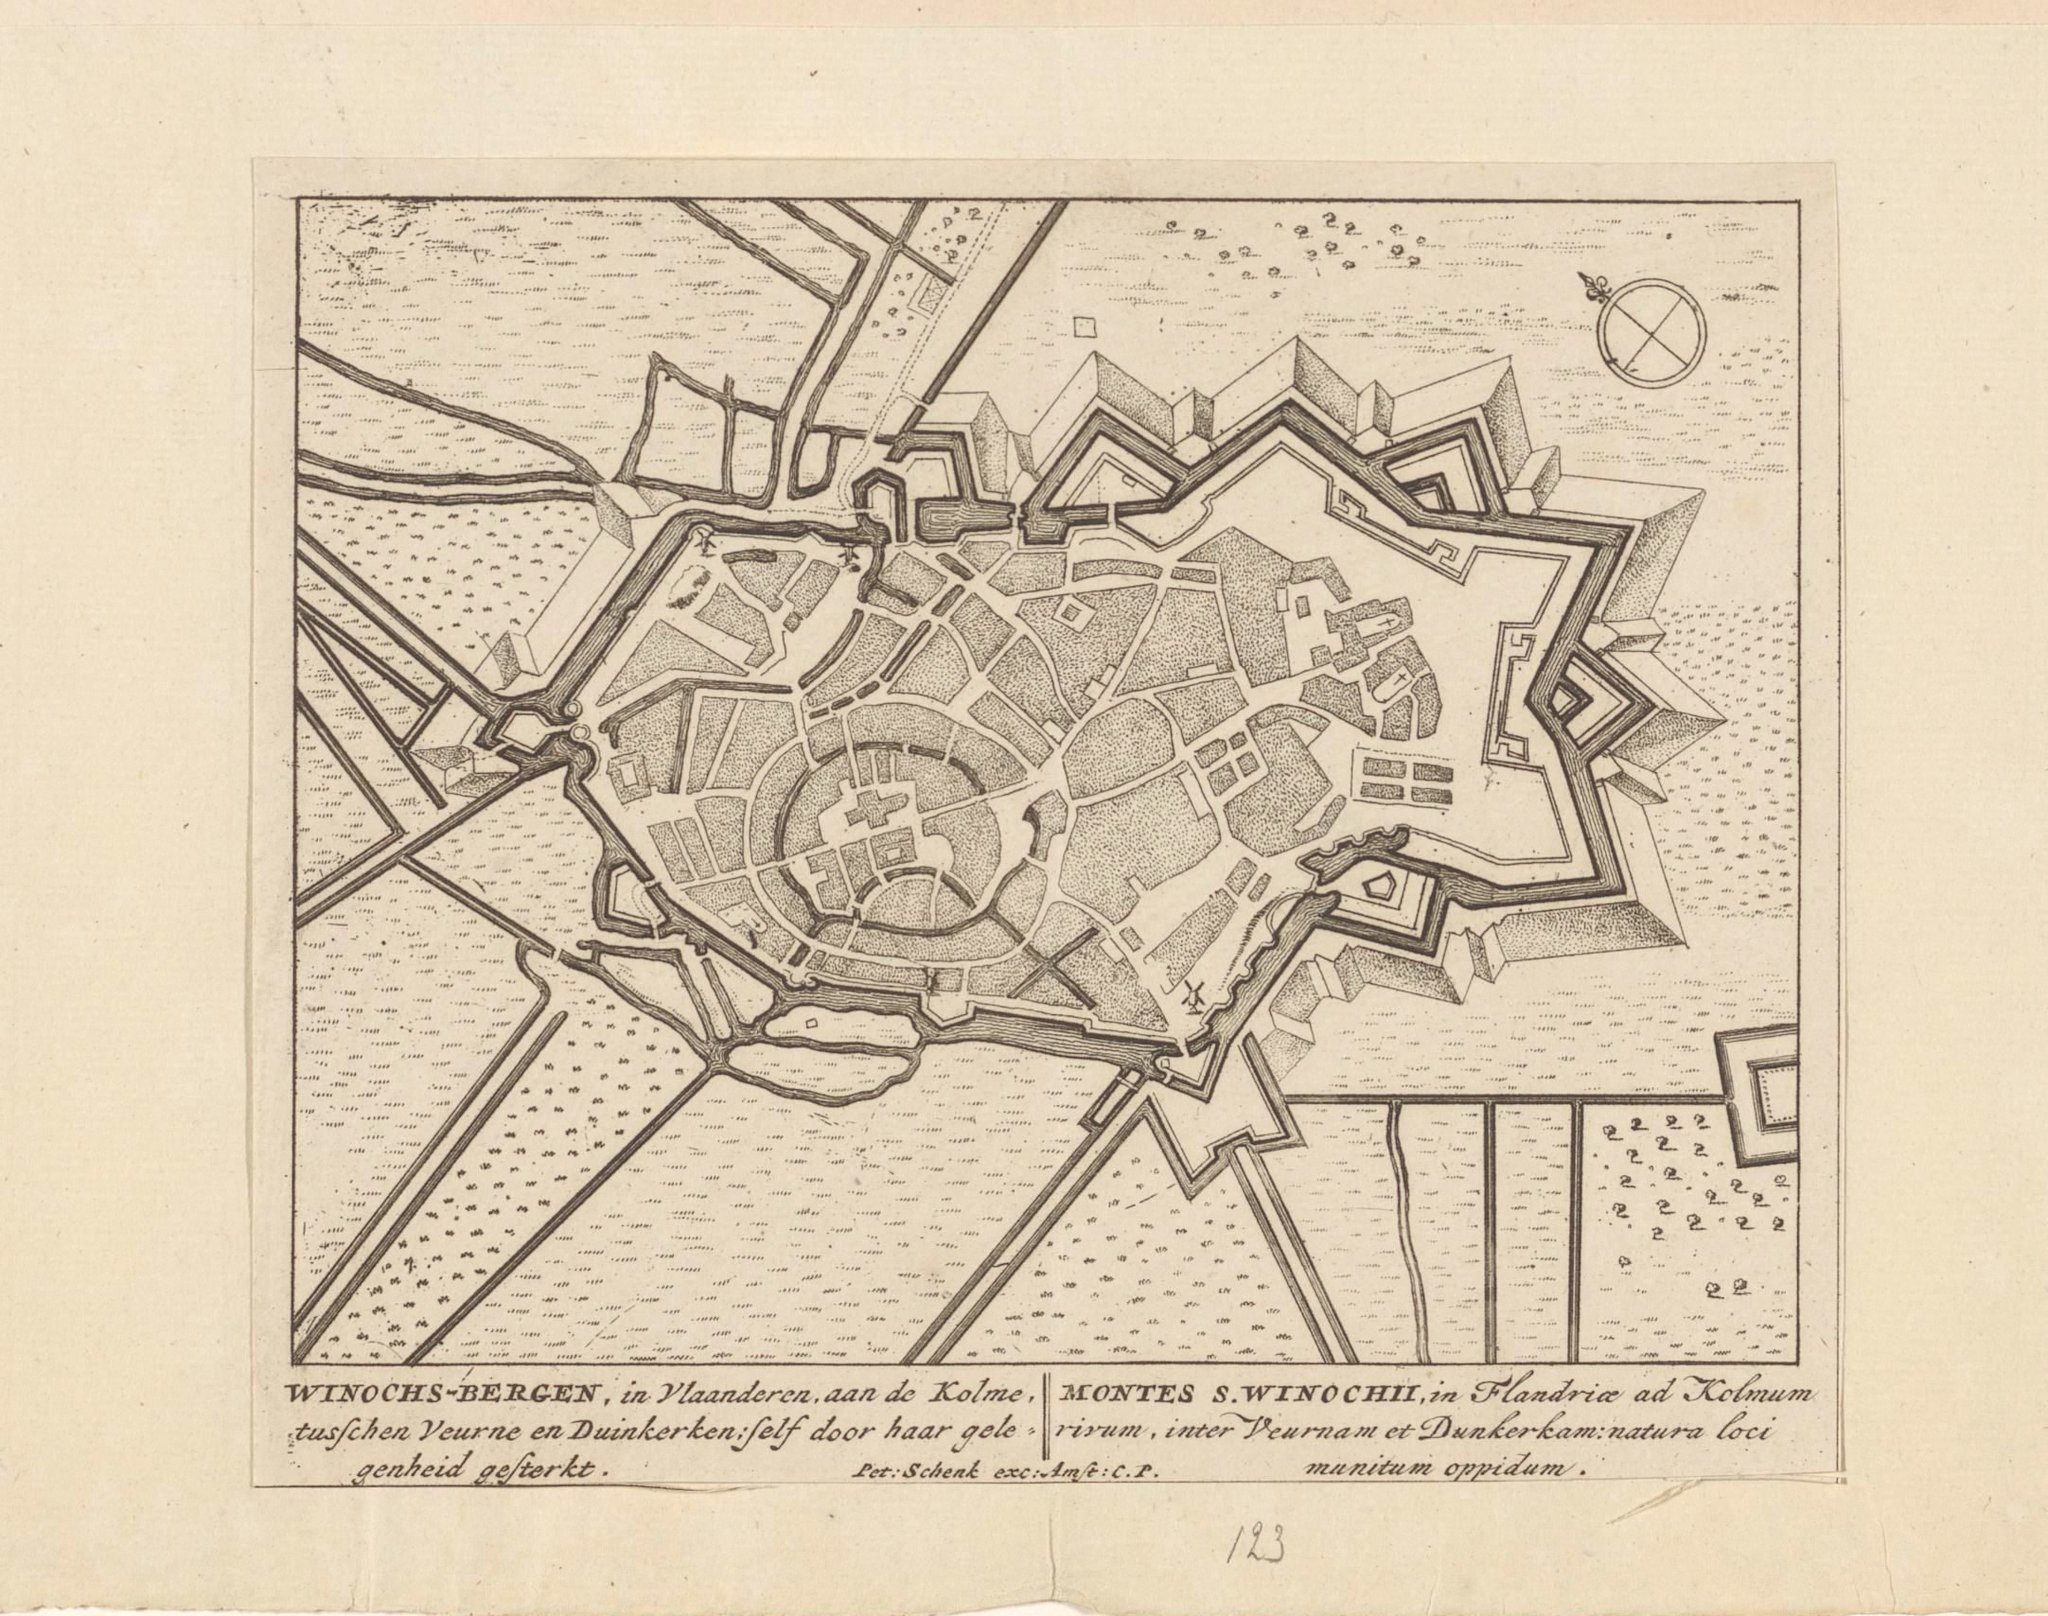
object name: area plan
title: Winochs-Bergen, in Vlaanderen, aan de Kolme, tusschen Veurne (...) / Montes S. Winochii, in Flandriae ad Kolmum rivum, inter Veurnam (...)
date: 1695-1711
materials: paper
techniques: engraving, etching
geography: amsterdam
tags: fortified city, maps of cities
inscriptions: collector's mark: Lugt 2228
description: Vestingplattegrond van Sint-Winoksbergen. Onder de voorstelling onderschriften in het Nederlands en Latijn.